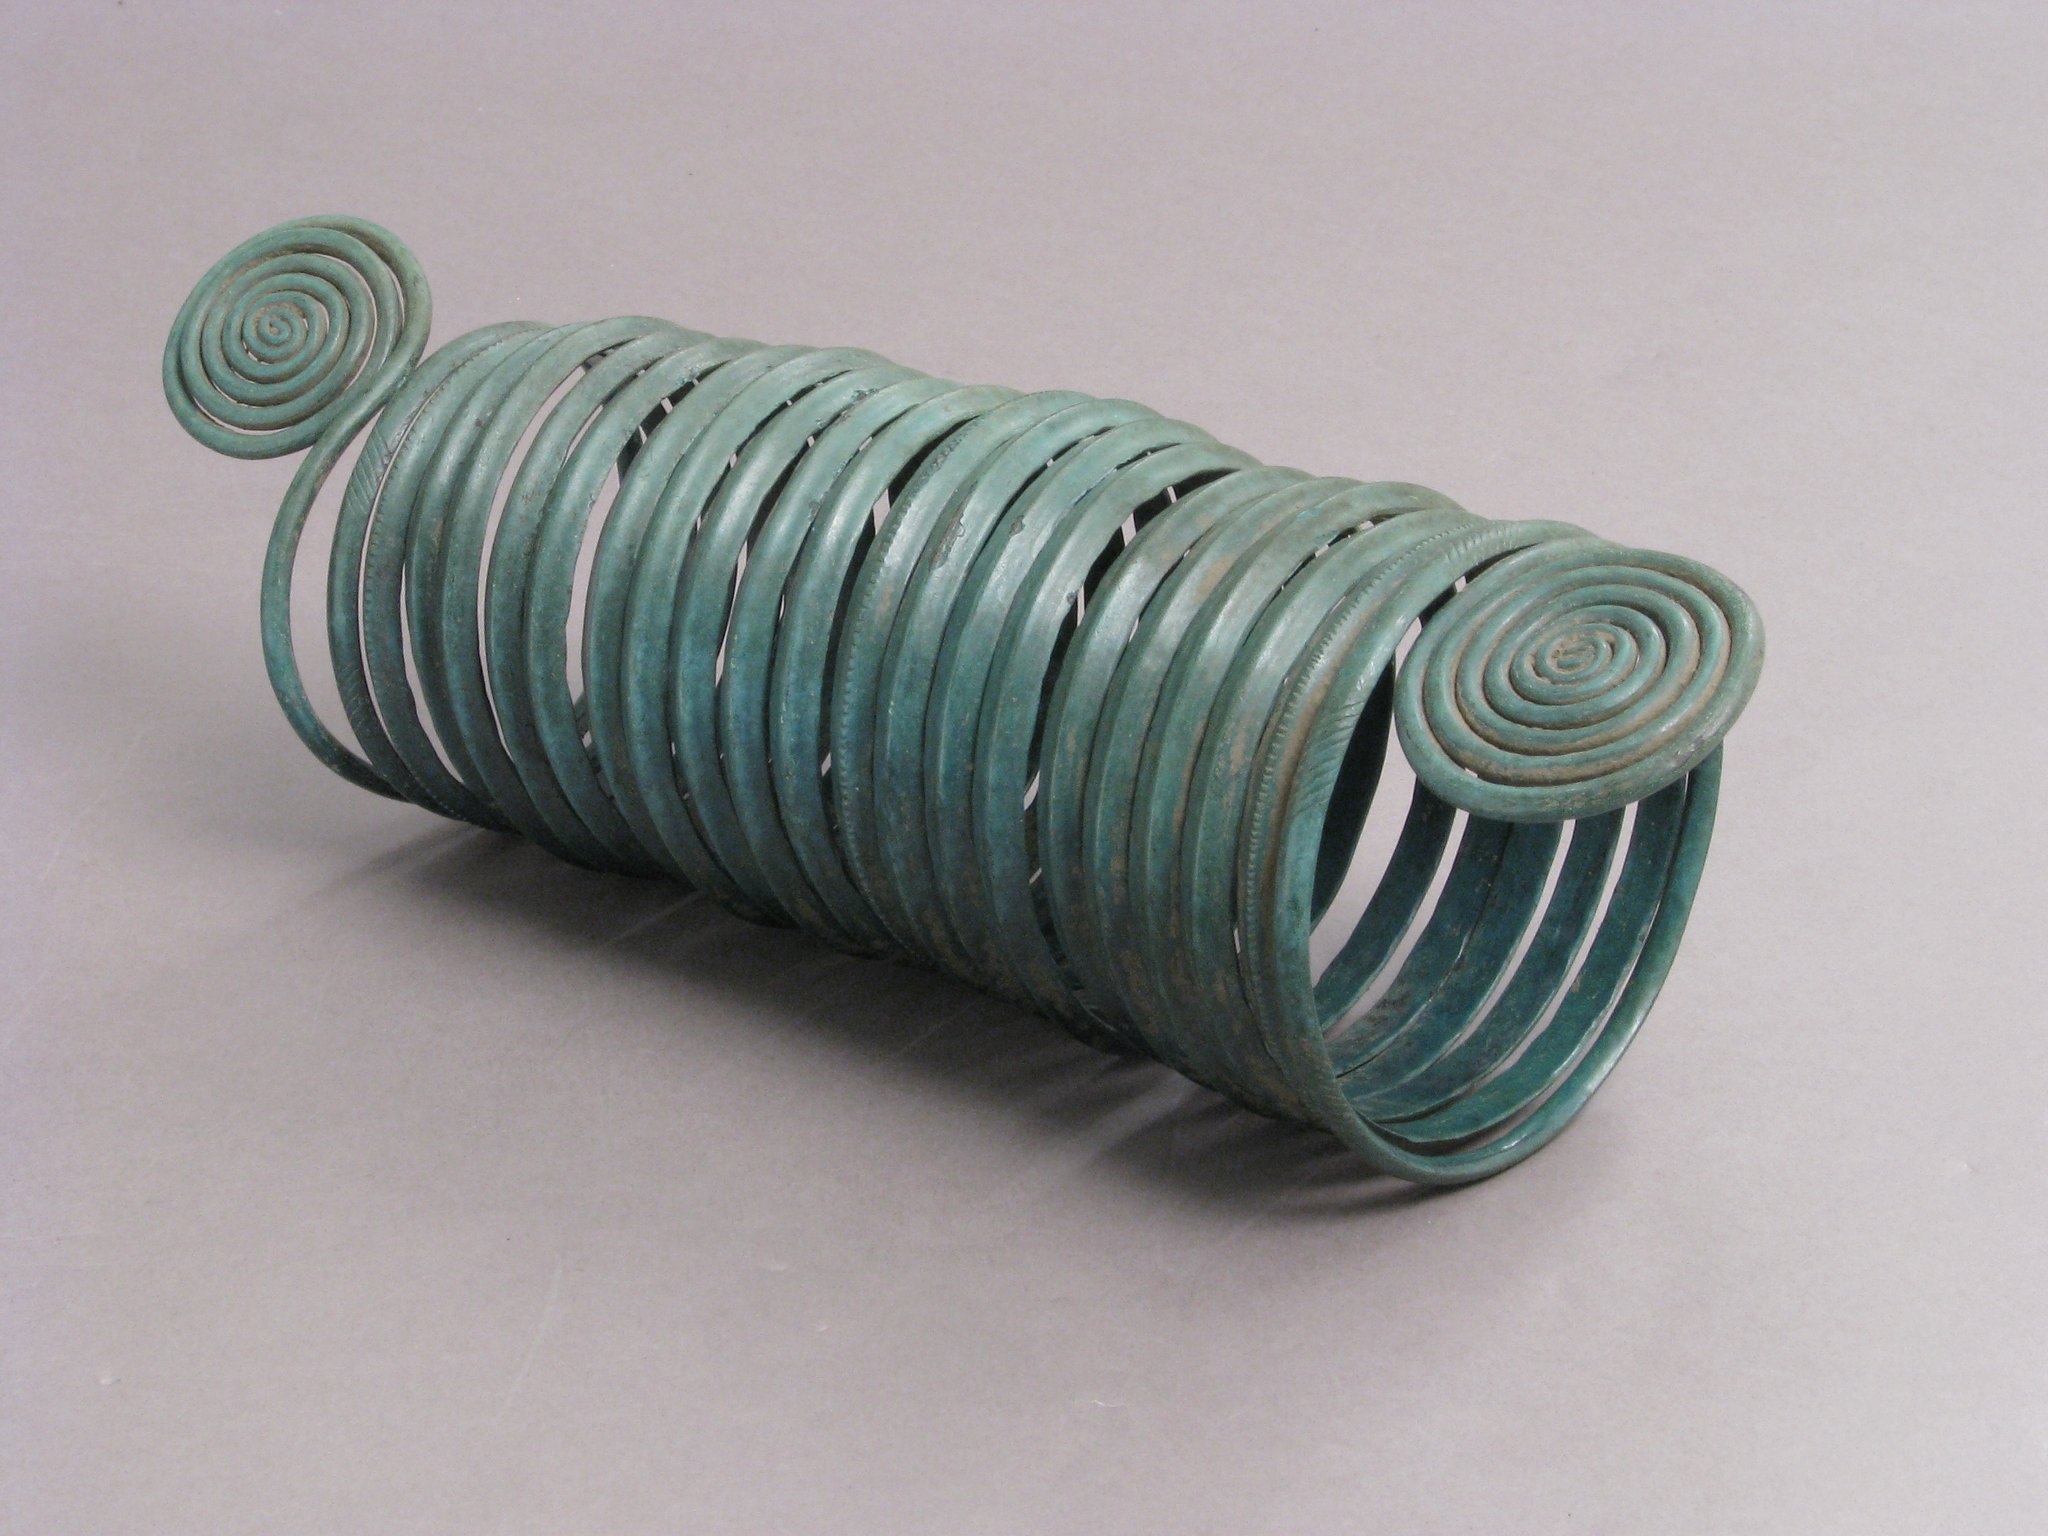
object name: armband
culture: european bronze age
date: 1200-900 BCE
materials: copper alloy